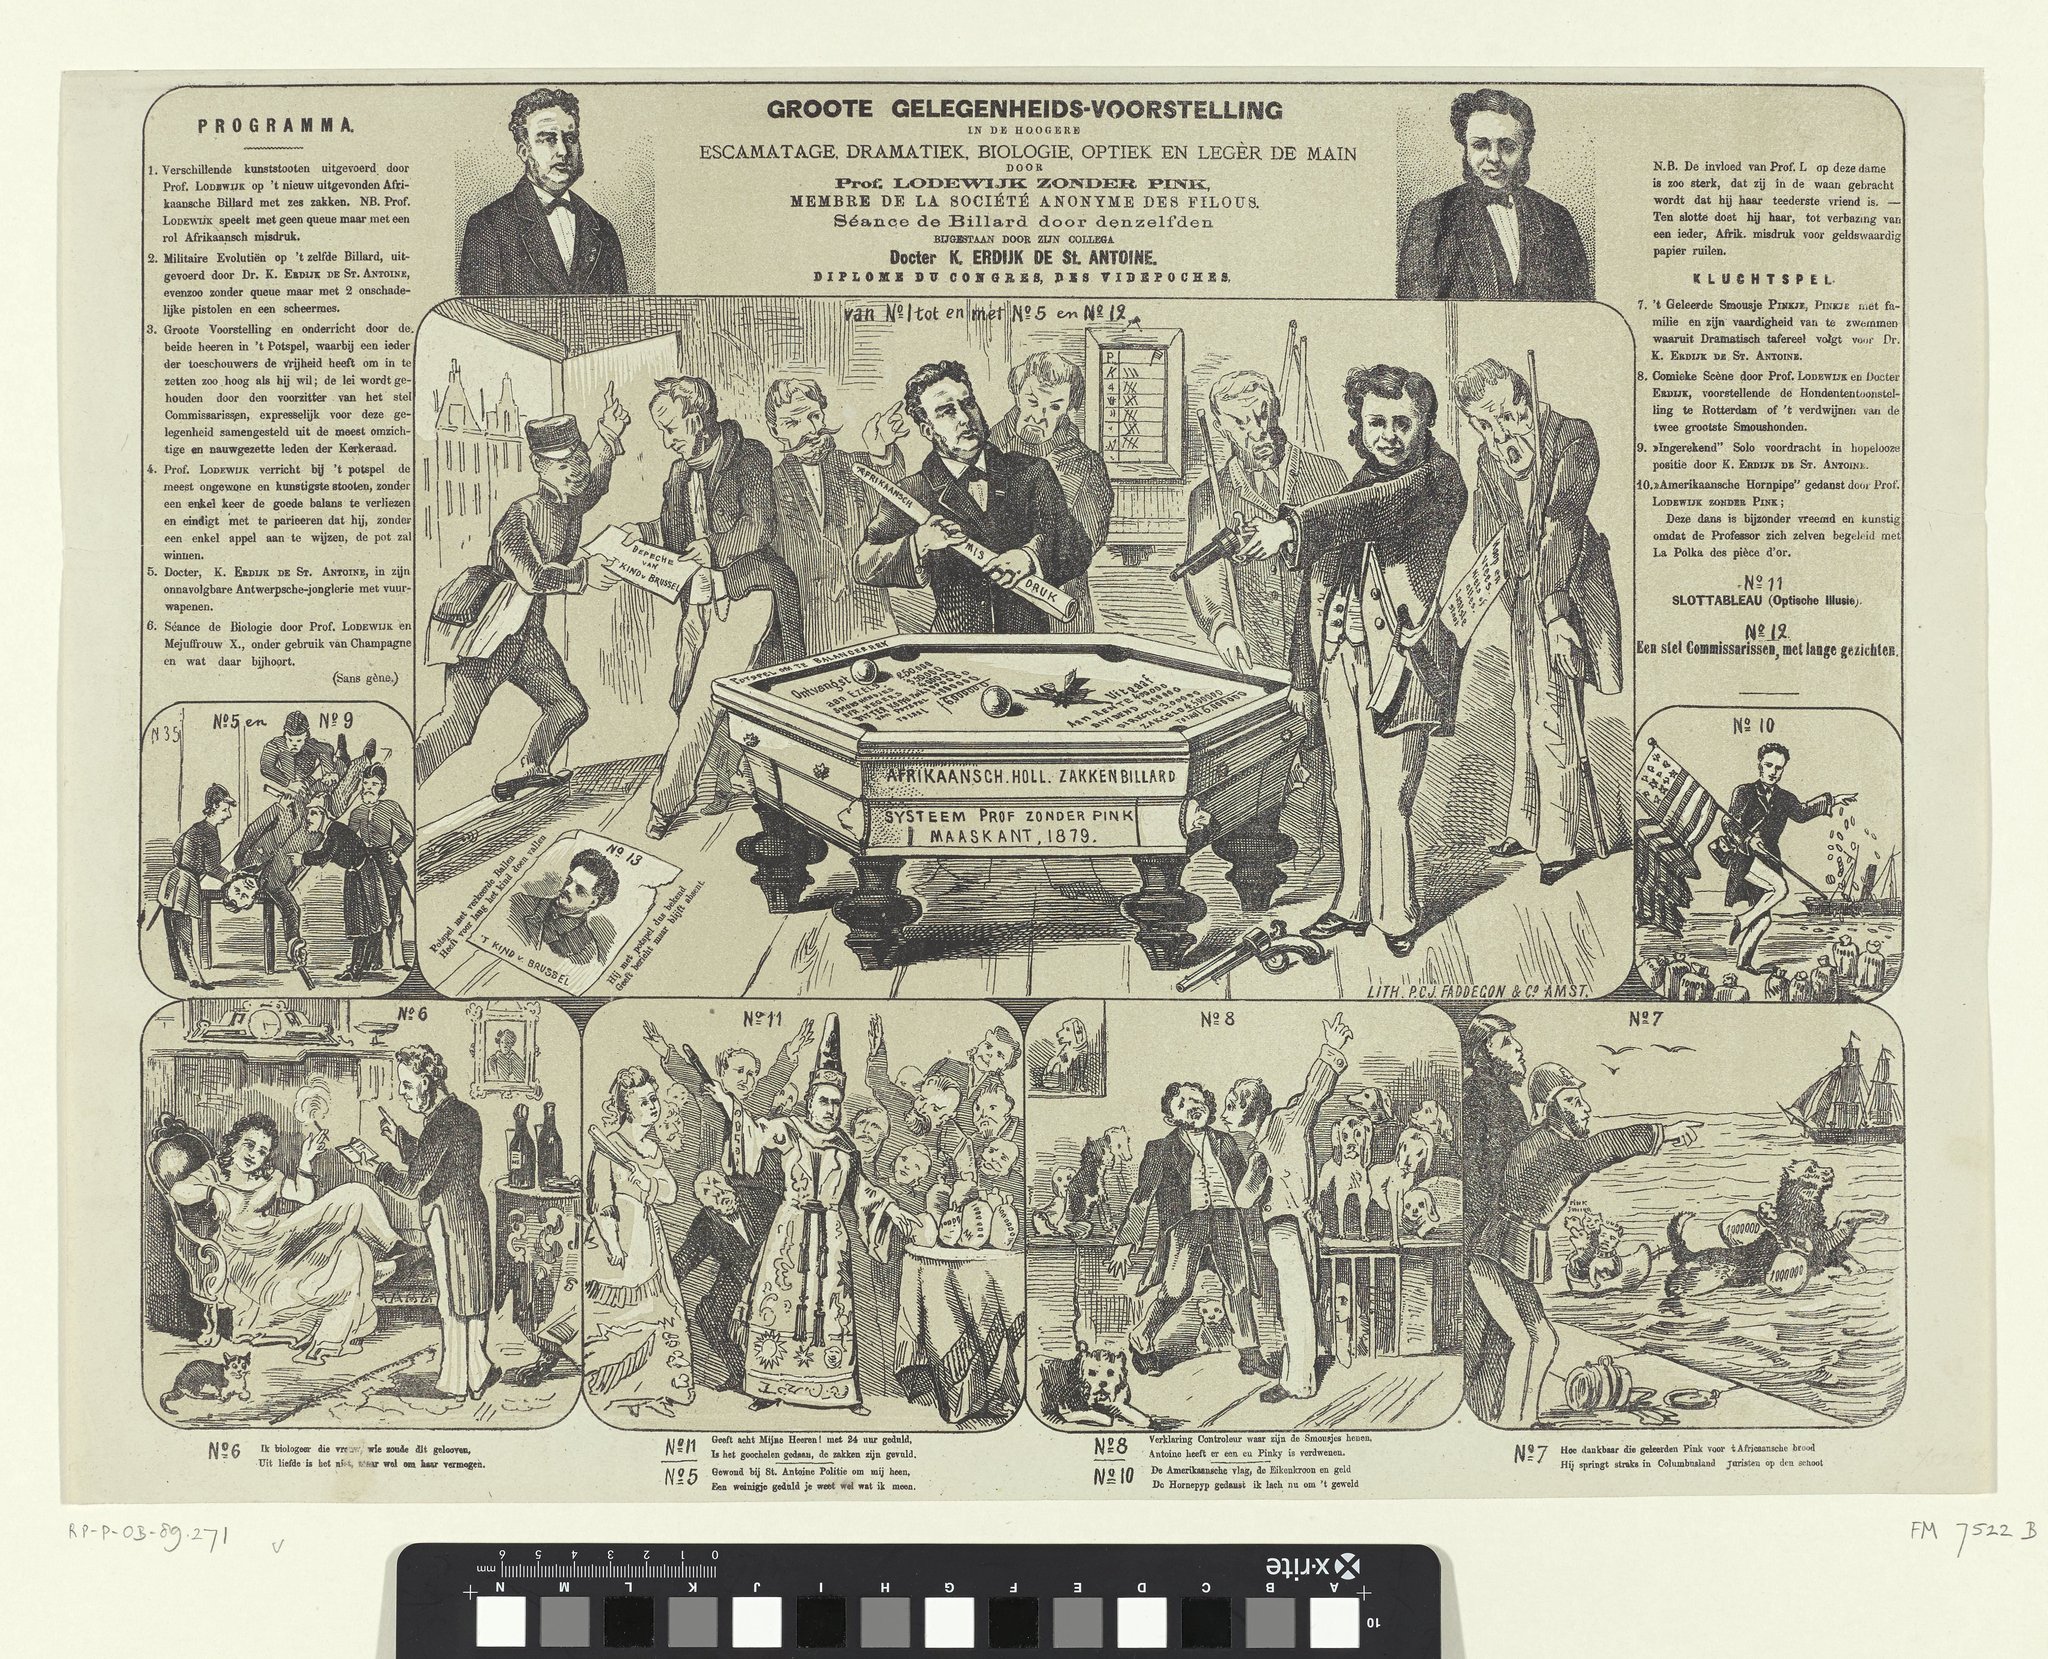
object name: print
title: Spotprent op Lodewijk Pincoffs, 1879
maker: Anonymous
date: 1879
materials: paper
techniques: tone lithography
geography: amsterdam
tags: rotterdam, billiards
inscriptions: collector's mark: Lugt 2228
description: Spotprent op de vlucht van Lodewijk Pincoffs naar de Verenigde Staten, na het aan het licht komen van de fraude door hem gepleegd me zijn Afrikaansche Handelsvereeniging te Rotterdam, 15 mei 1879. Centraal een grote voorstelling met Pincoffs met anderen rond een biljarttafel. Hieromheen zes kleine scènes, bovenaan portretten van Pincoffs en zijn compagnon Kerdijk.